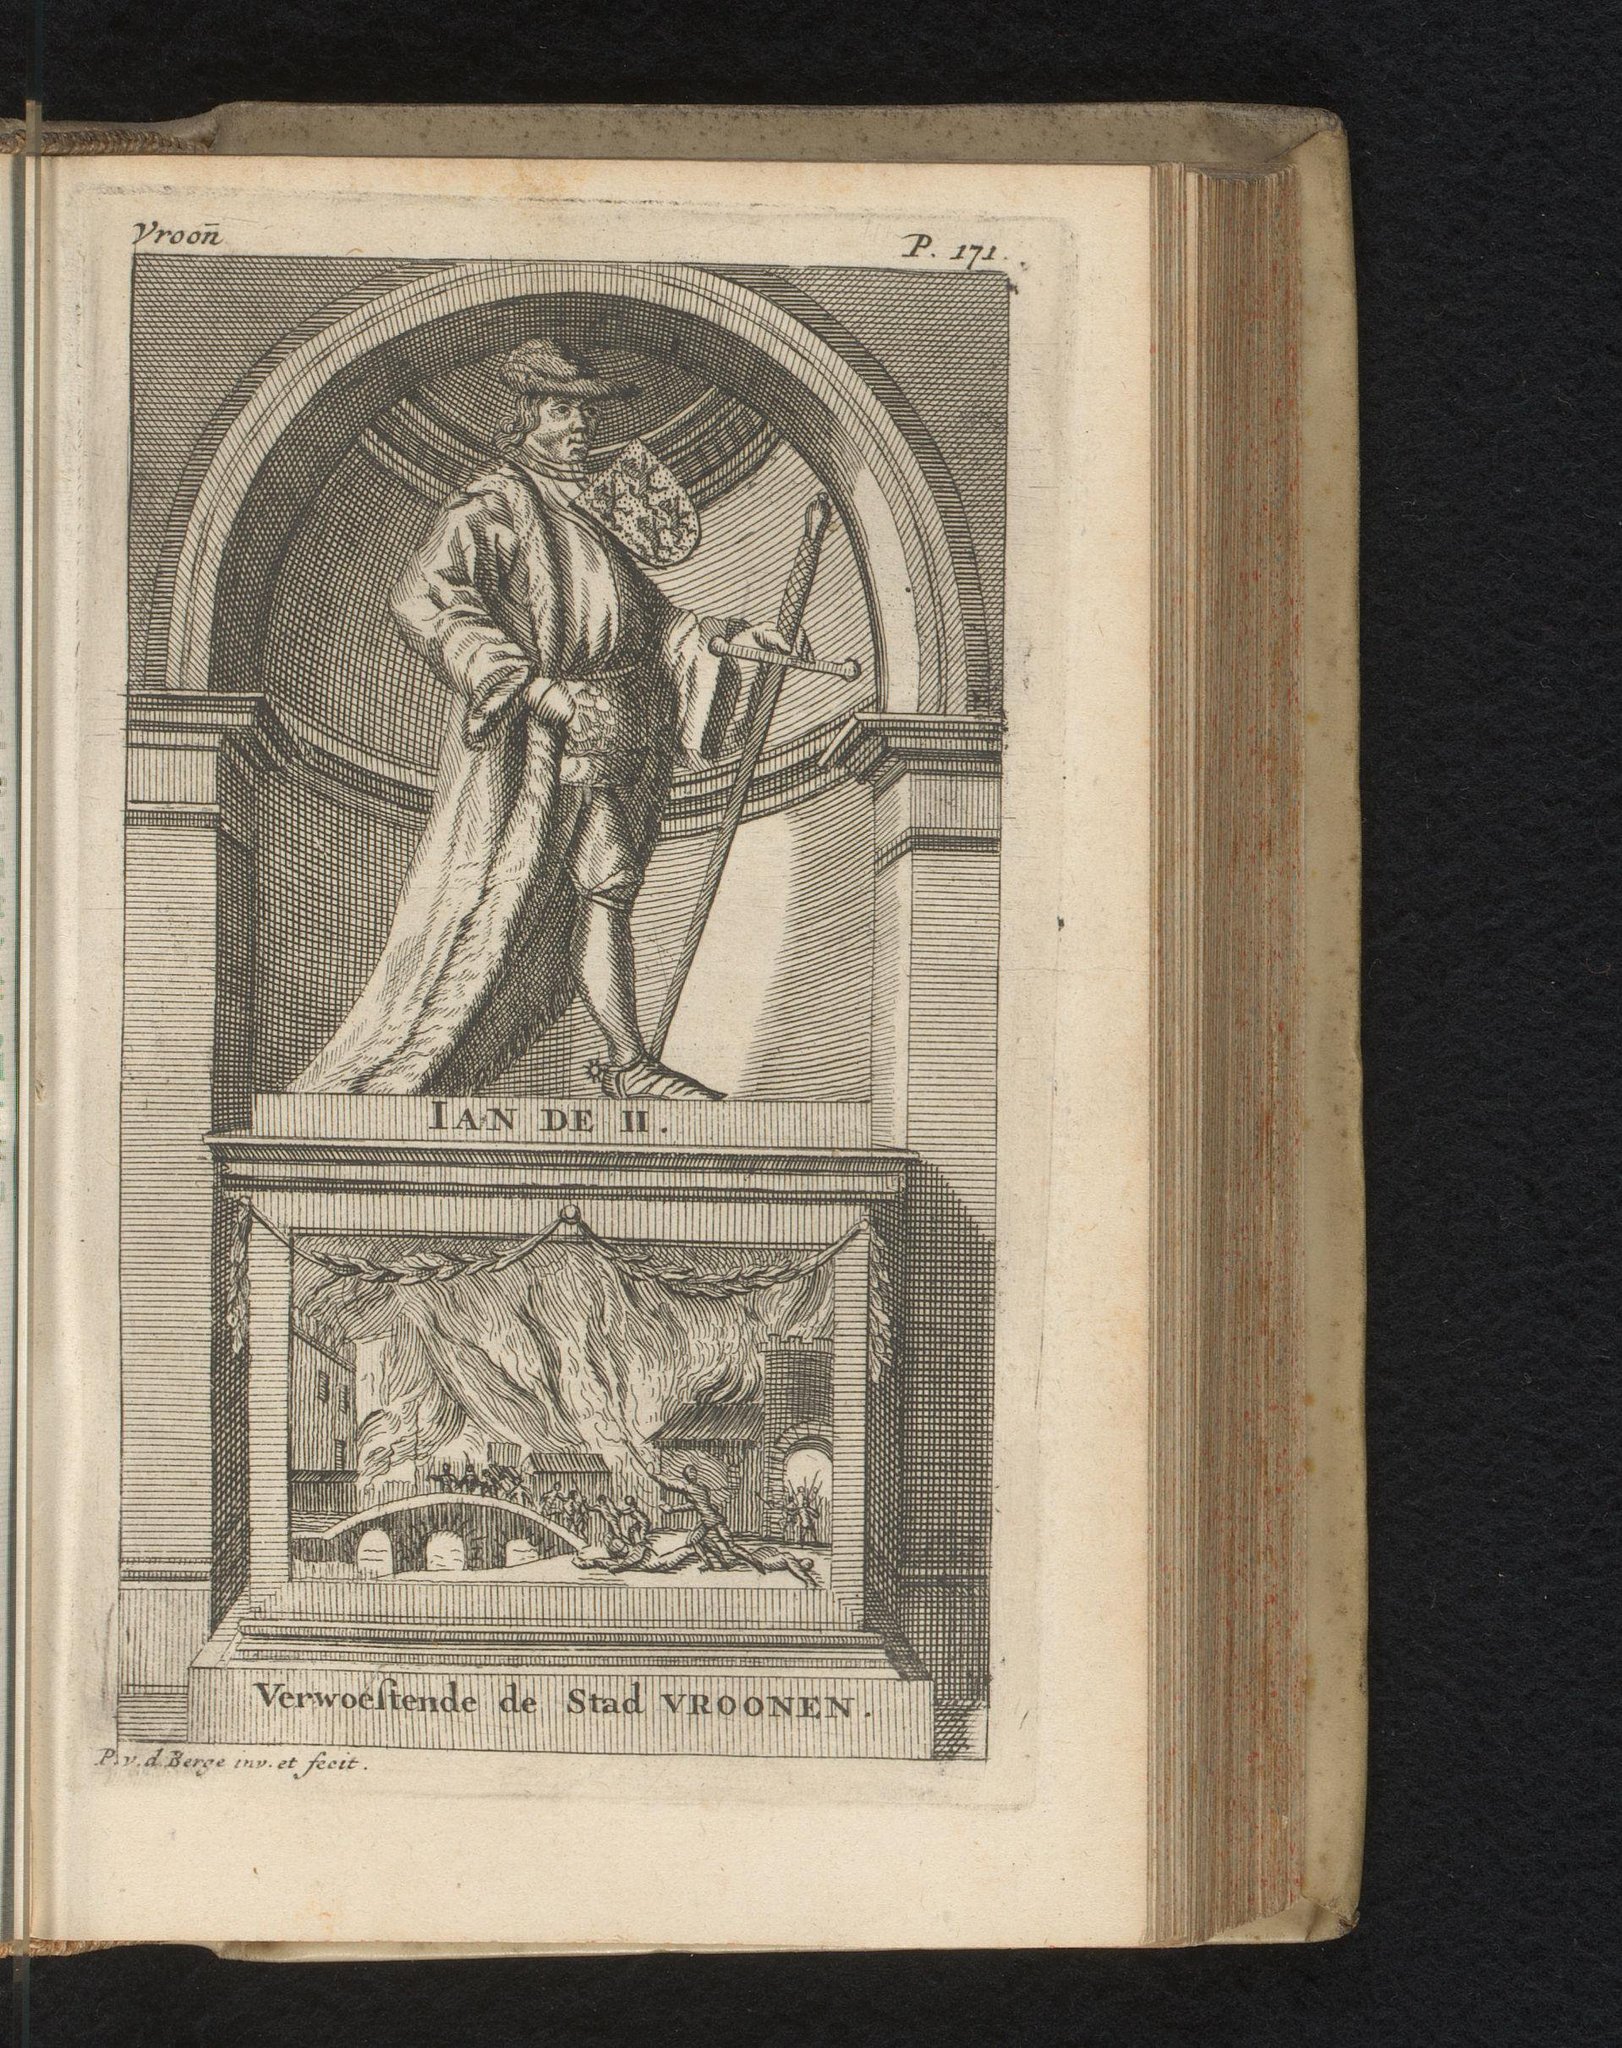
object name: print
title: Jan de II. Verwoestende de stad Vroonen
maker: pieter van den berge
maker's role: draughtsman, print maker, printer, publisher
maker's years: 1659-1737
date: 1700-1702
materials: paper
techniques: etching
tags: jan ii (graaf van holland), vronen, nederland tijdens de late middeleeuwen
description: Illustratie in: H. Soeteboom, Oud-heden van Zaan-land, Stavoren, Vronen en Waterland : deze laatste druk ... met nodige aanteekeningen, figuren, en een landkaart verrykt / Vroonens Begin Midden en Eynde, W. Linnig van Koppenol, Amsterdam 1702, dl. 2, ingebonden tussen p. 170/171.